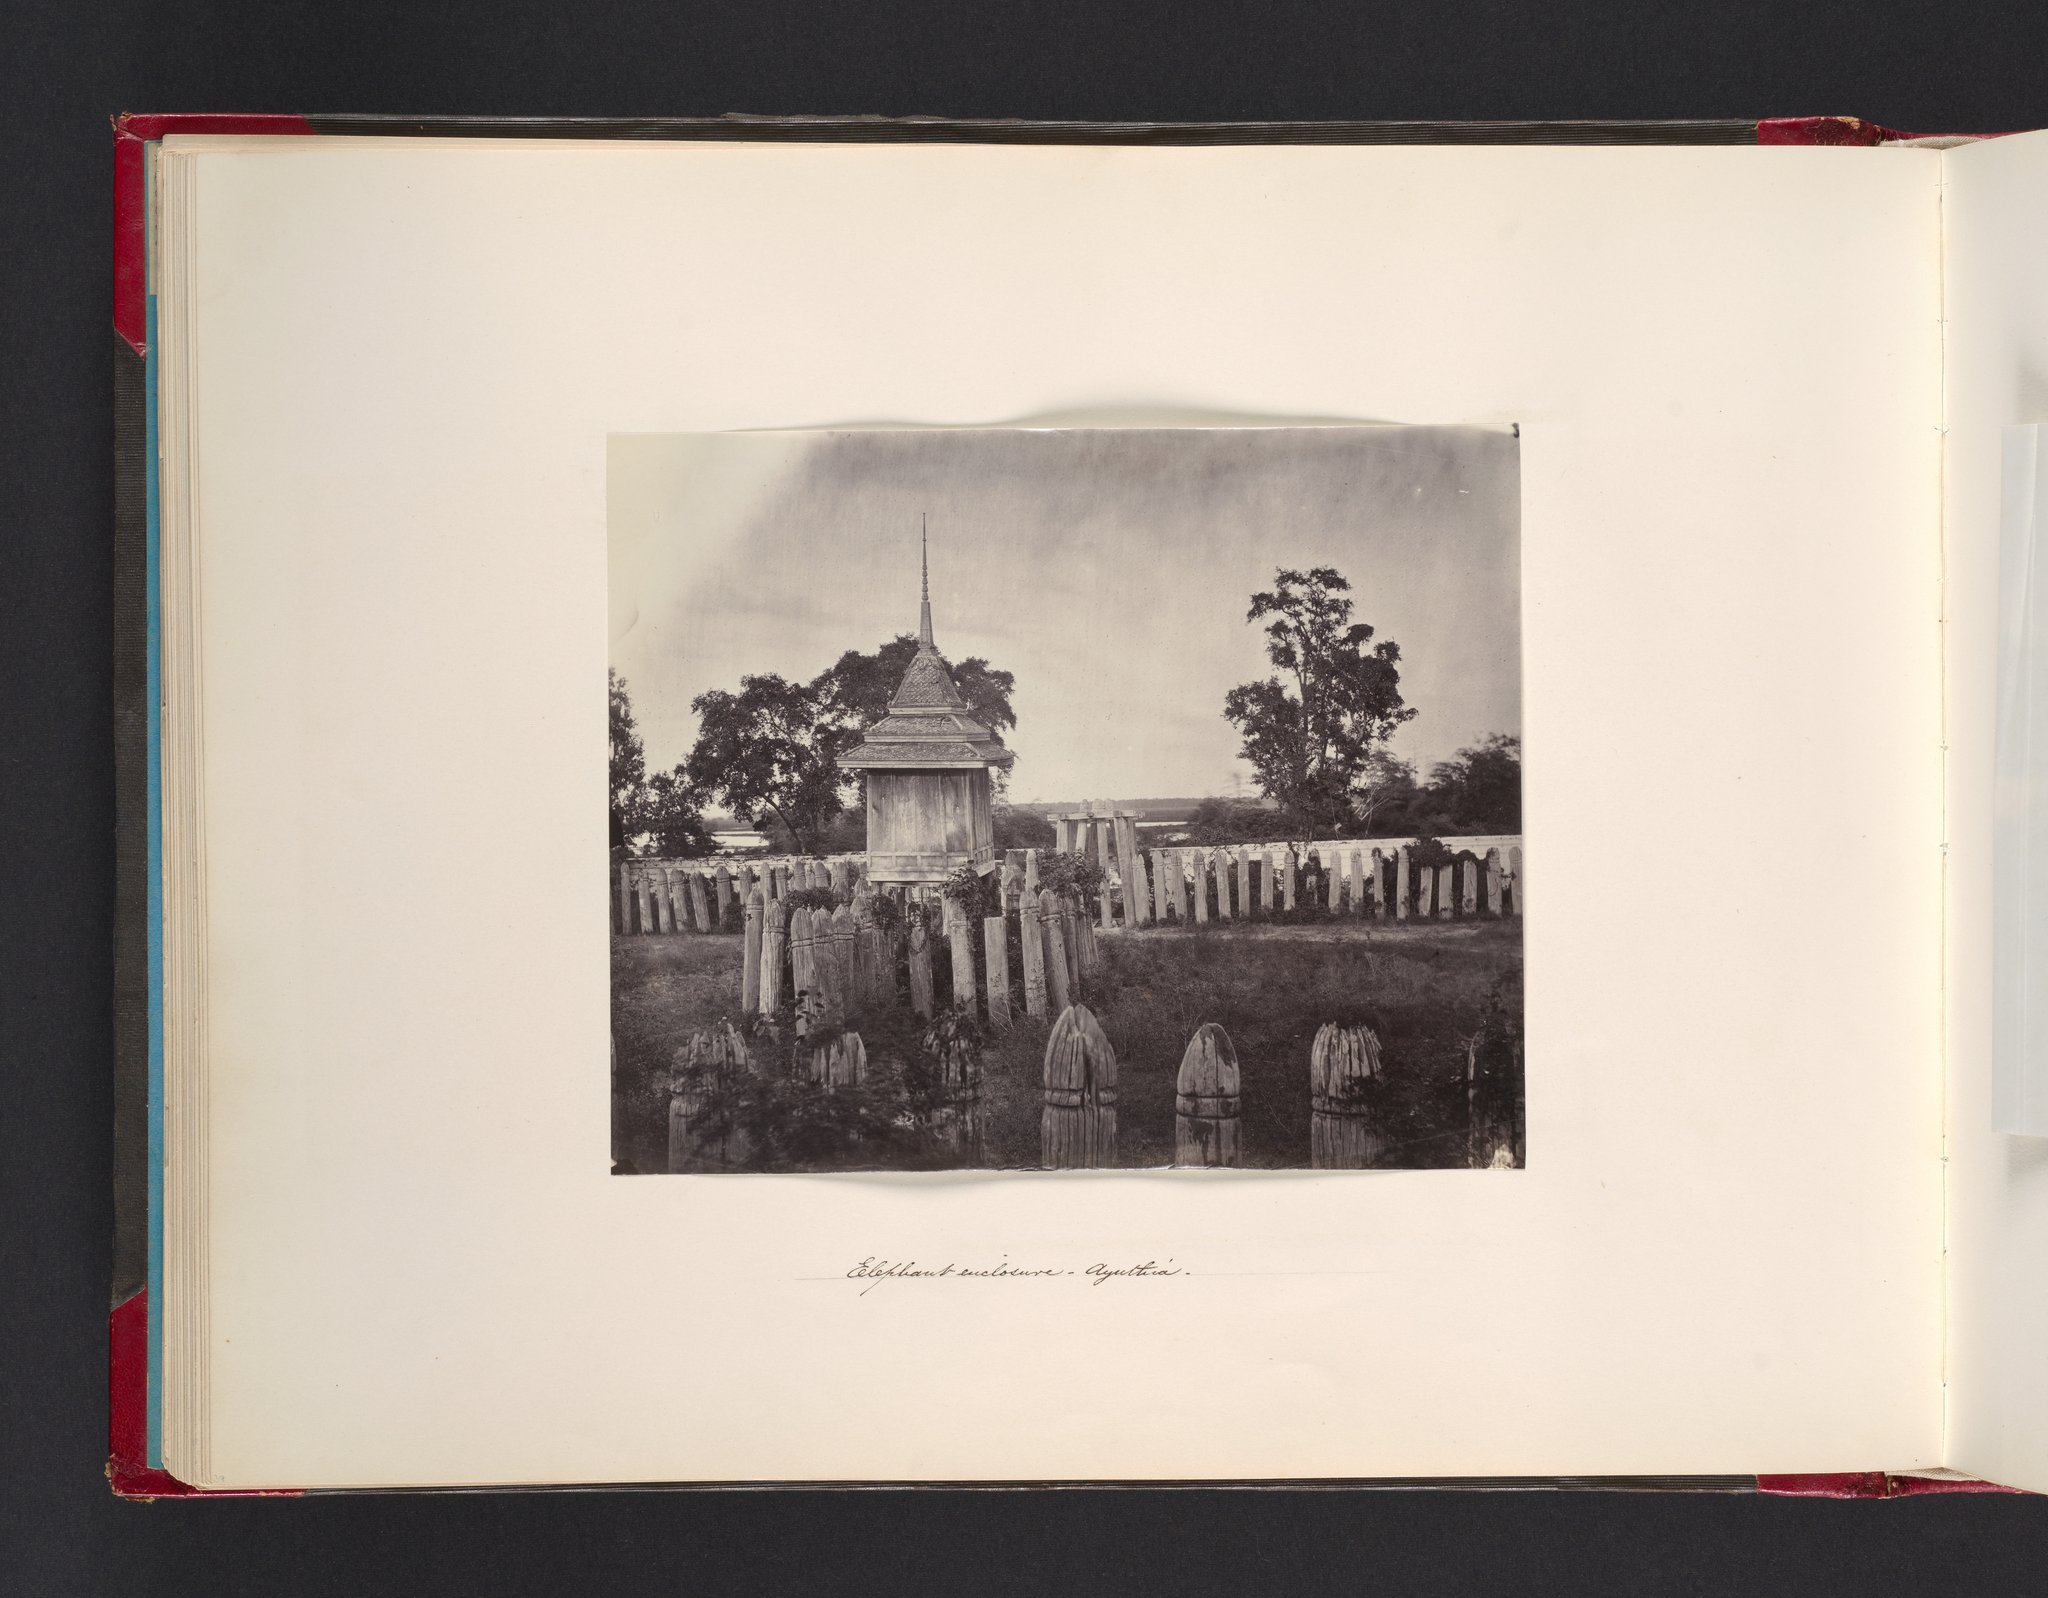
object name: photograph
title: Elephant Enclosure, Ayuthia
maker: john thomson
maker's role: artist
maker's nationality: british, scottish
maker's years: 1837-1921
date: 1865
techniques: albumen silver print, glass negative